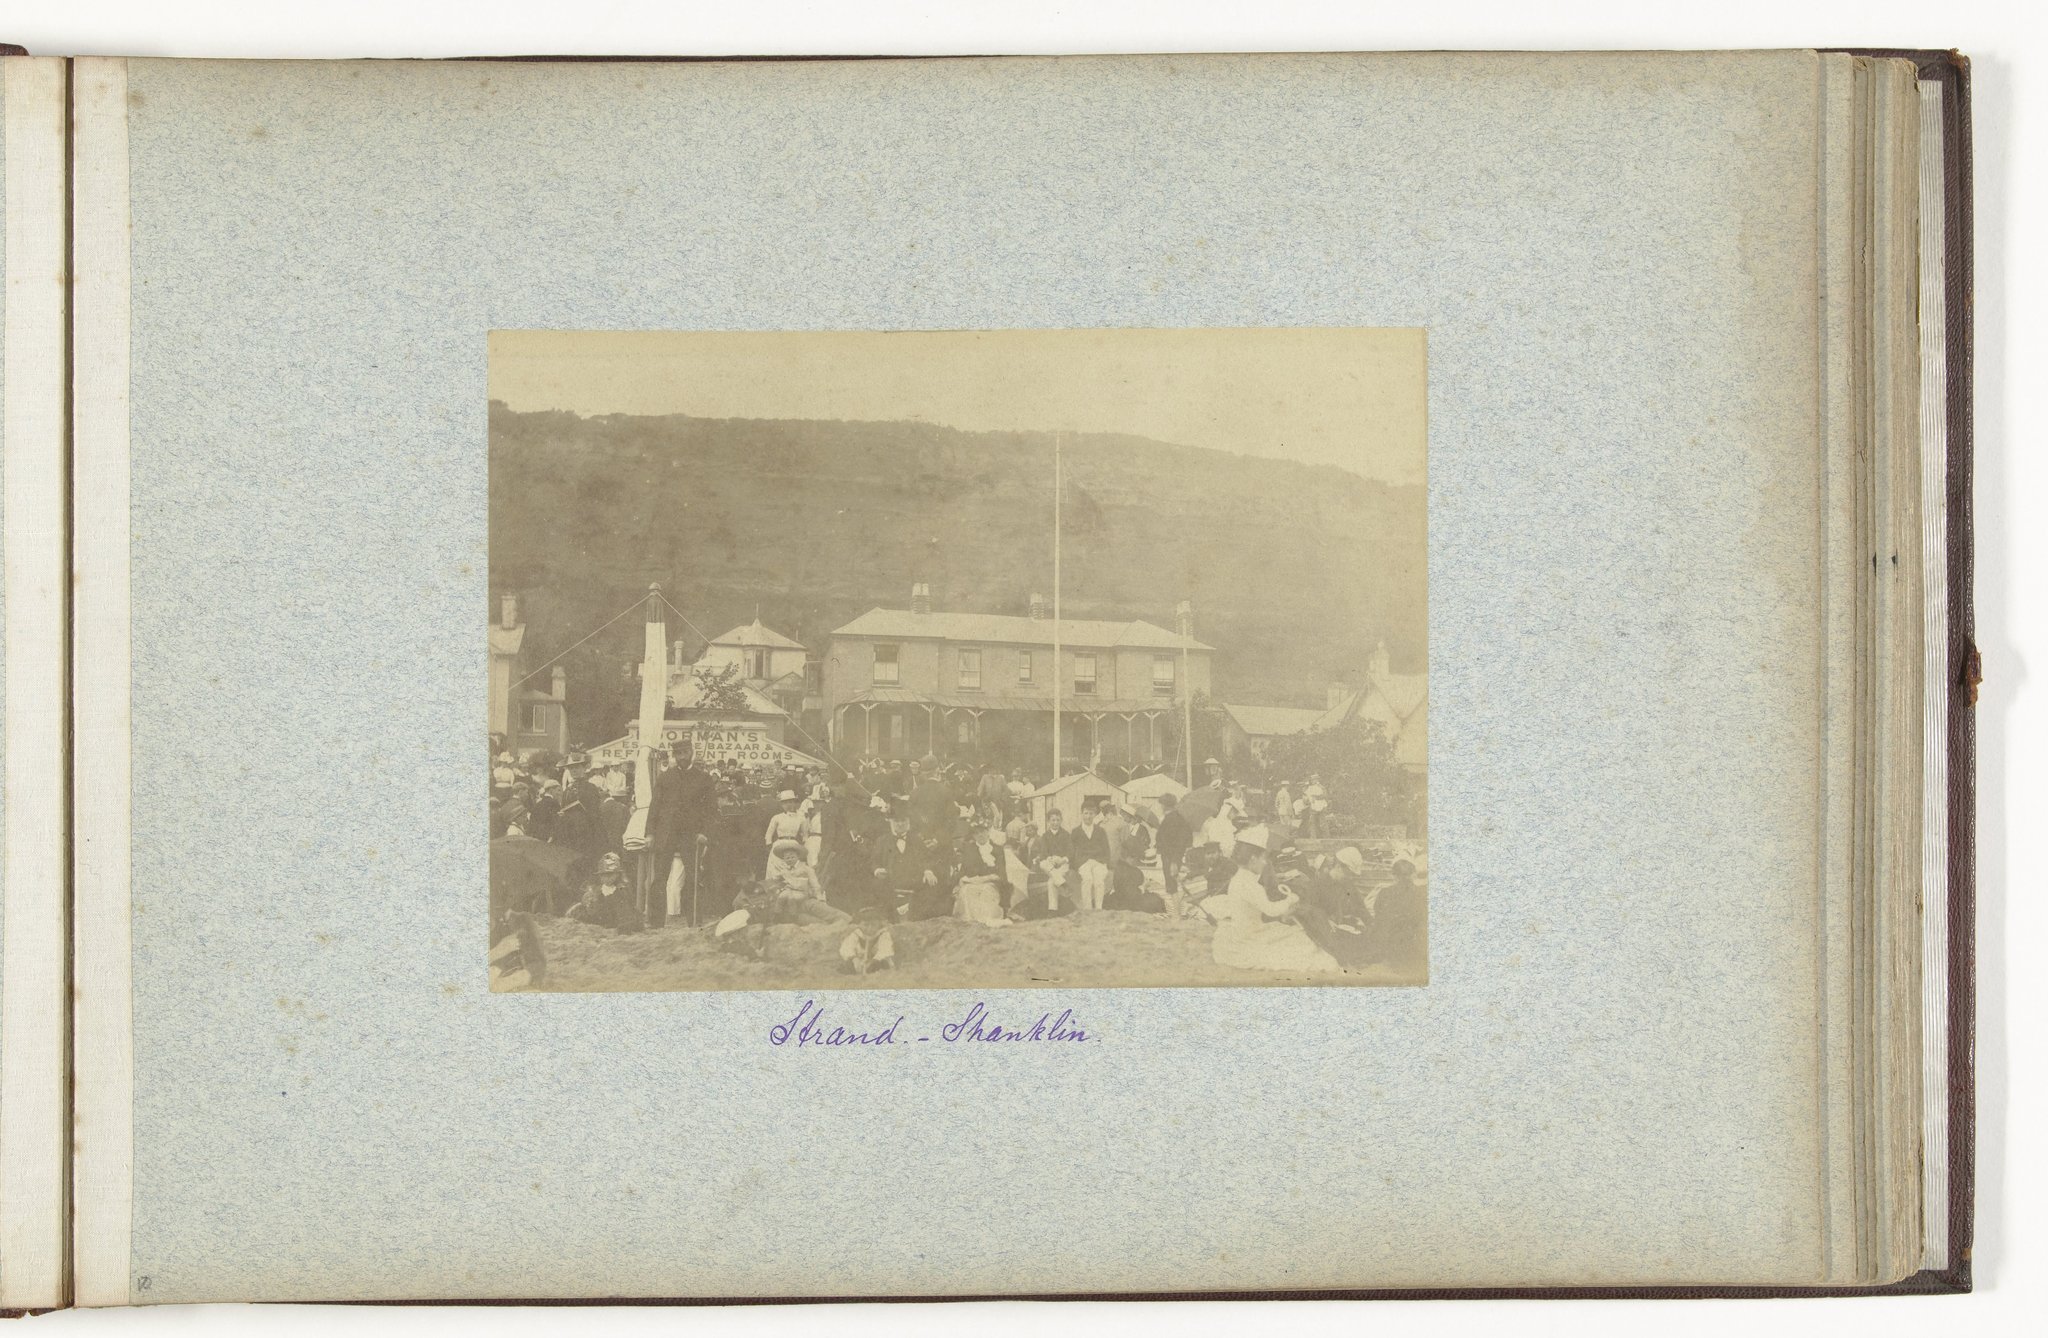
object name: photograph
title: Strand.- Shanklin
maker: henry pauw van wieldrecht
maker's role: fotograaf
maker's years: 1863-1912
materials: cardboard, paper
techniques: albumen print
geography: shanklin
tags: beach (as place of recreation), anonymous historical persons portrayed in a group, in a group-portrait